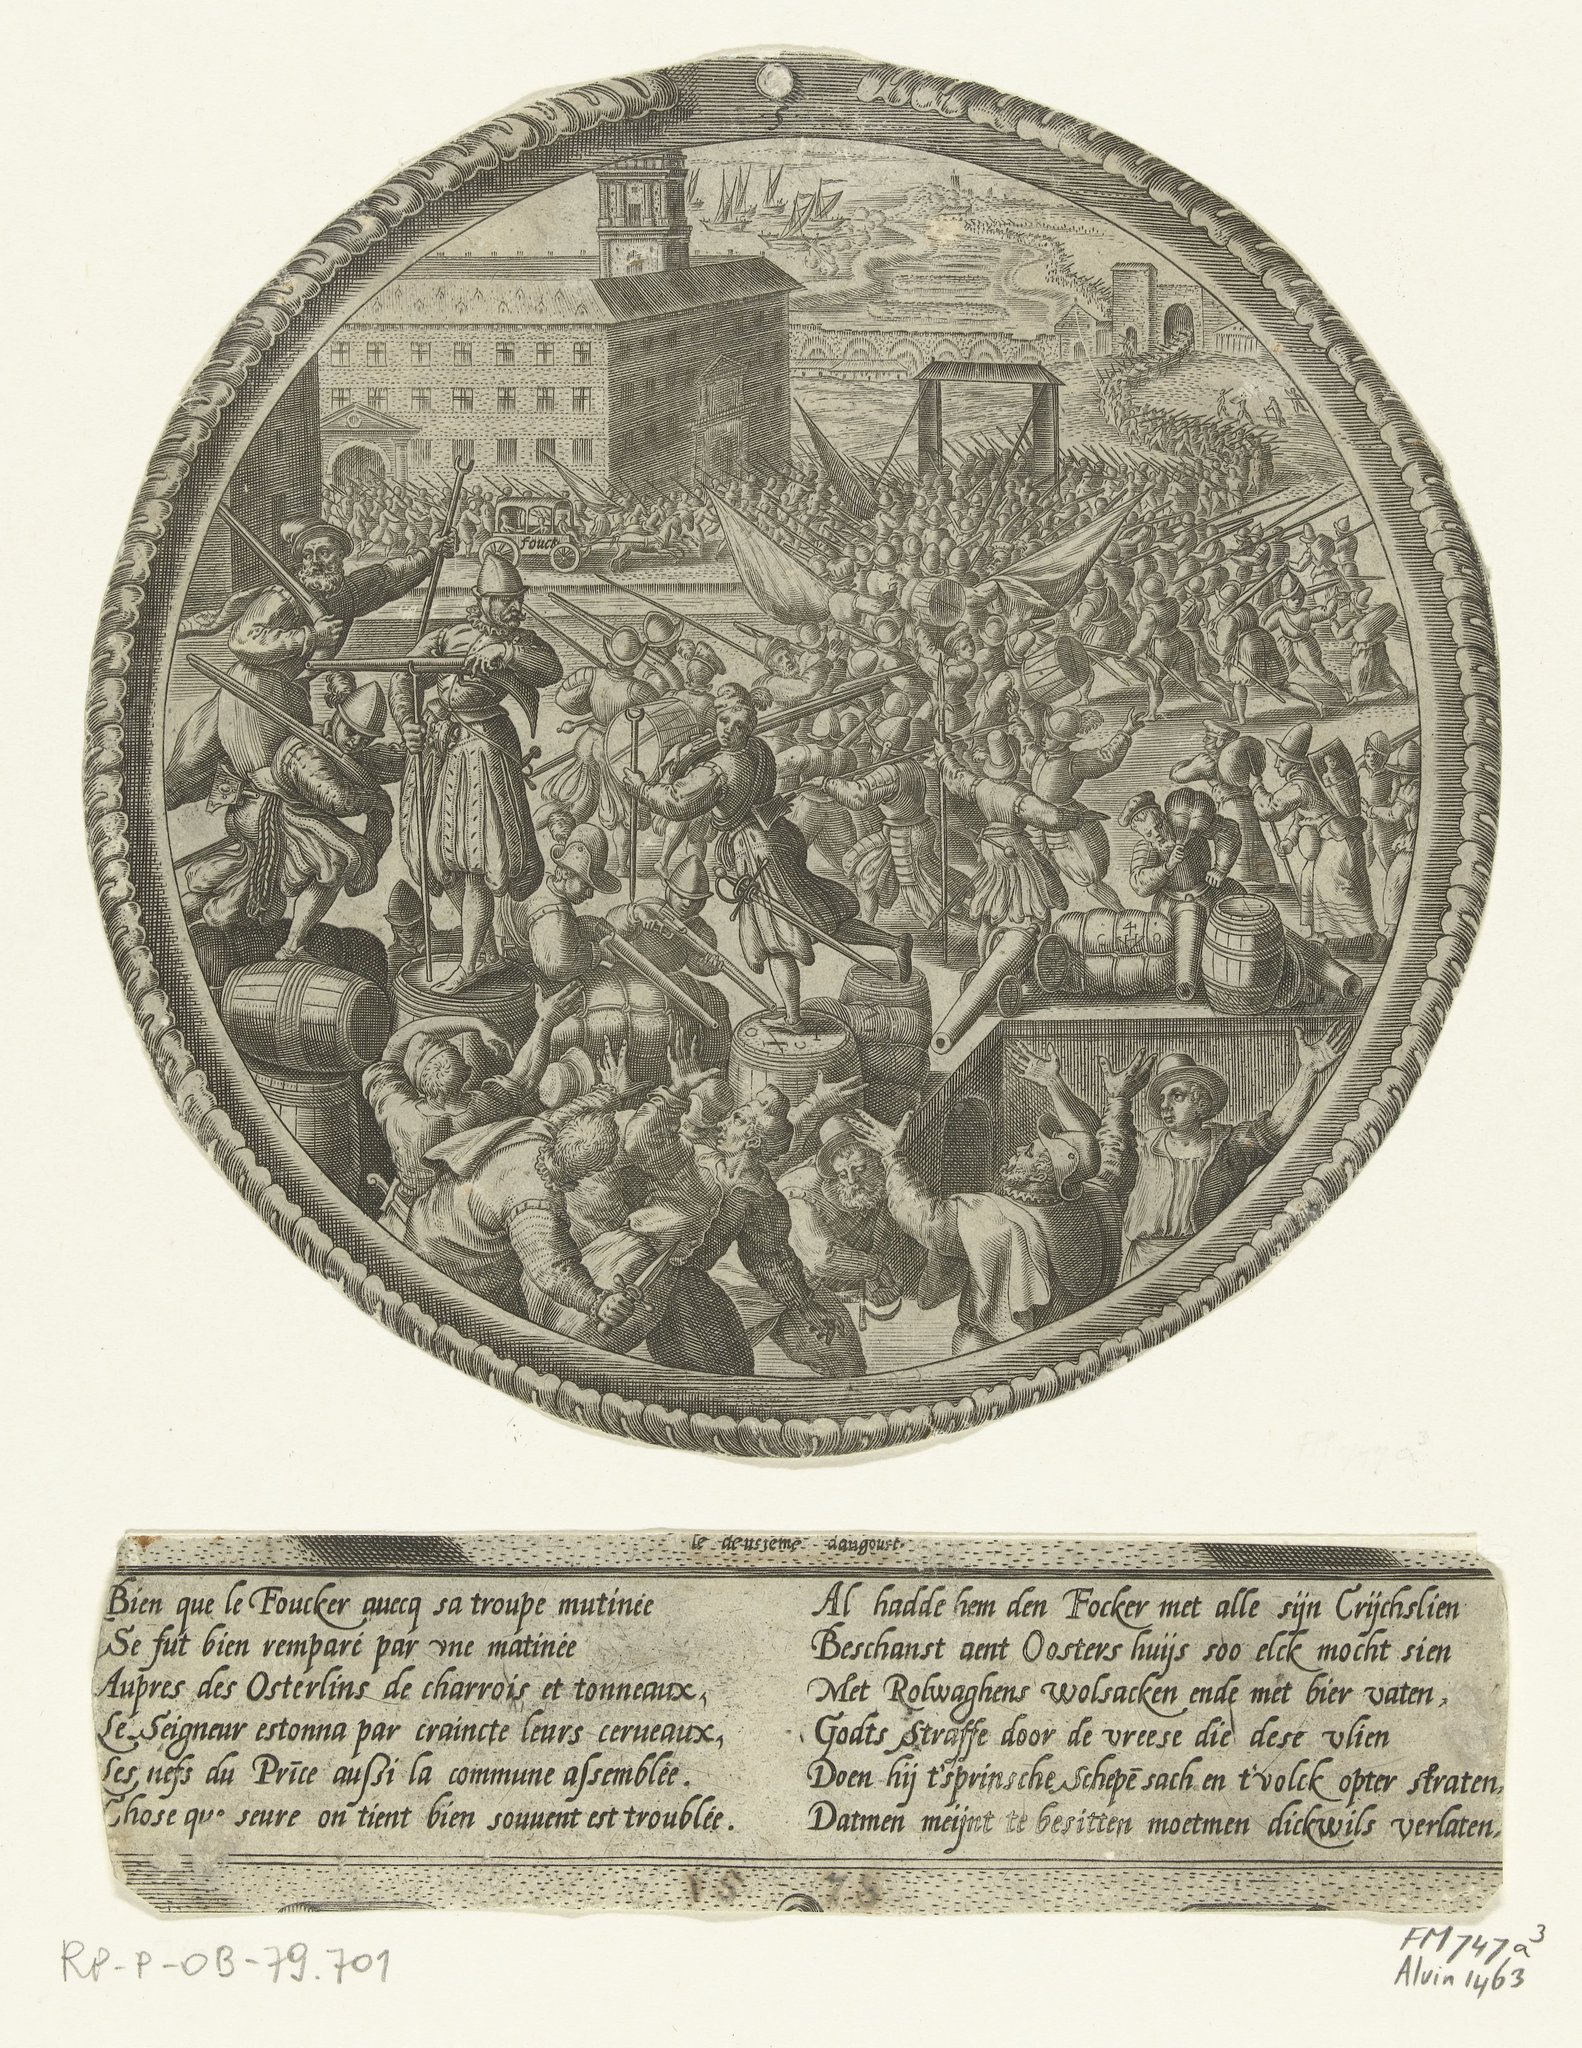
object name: propagandaprent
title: Medaillons met de verovering van de citadel van Antwerpen in 1577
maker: wierix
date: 1578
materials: paper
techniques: engraving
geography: netherlands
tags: plundering ~ soldiers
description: Paniek onder de Duitse soldaten door de aankomst van enkele schepen van de prins van Oranje, 2 augustus 1577. Soldaten met hun buit op straat voor het Oosters Huis. Alleen twee fragmenten van de prent aanwezig: de voorstelling in een rond medaillon en de cartouche met 2 verzen van elk 6 regels in het Frans en Nederlands.